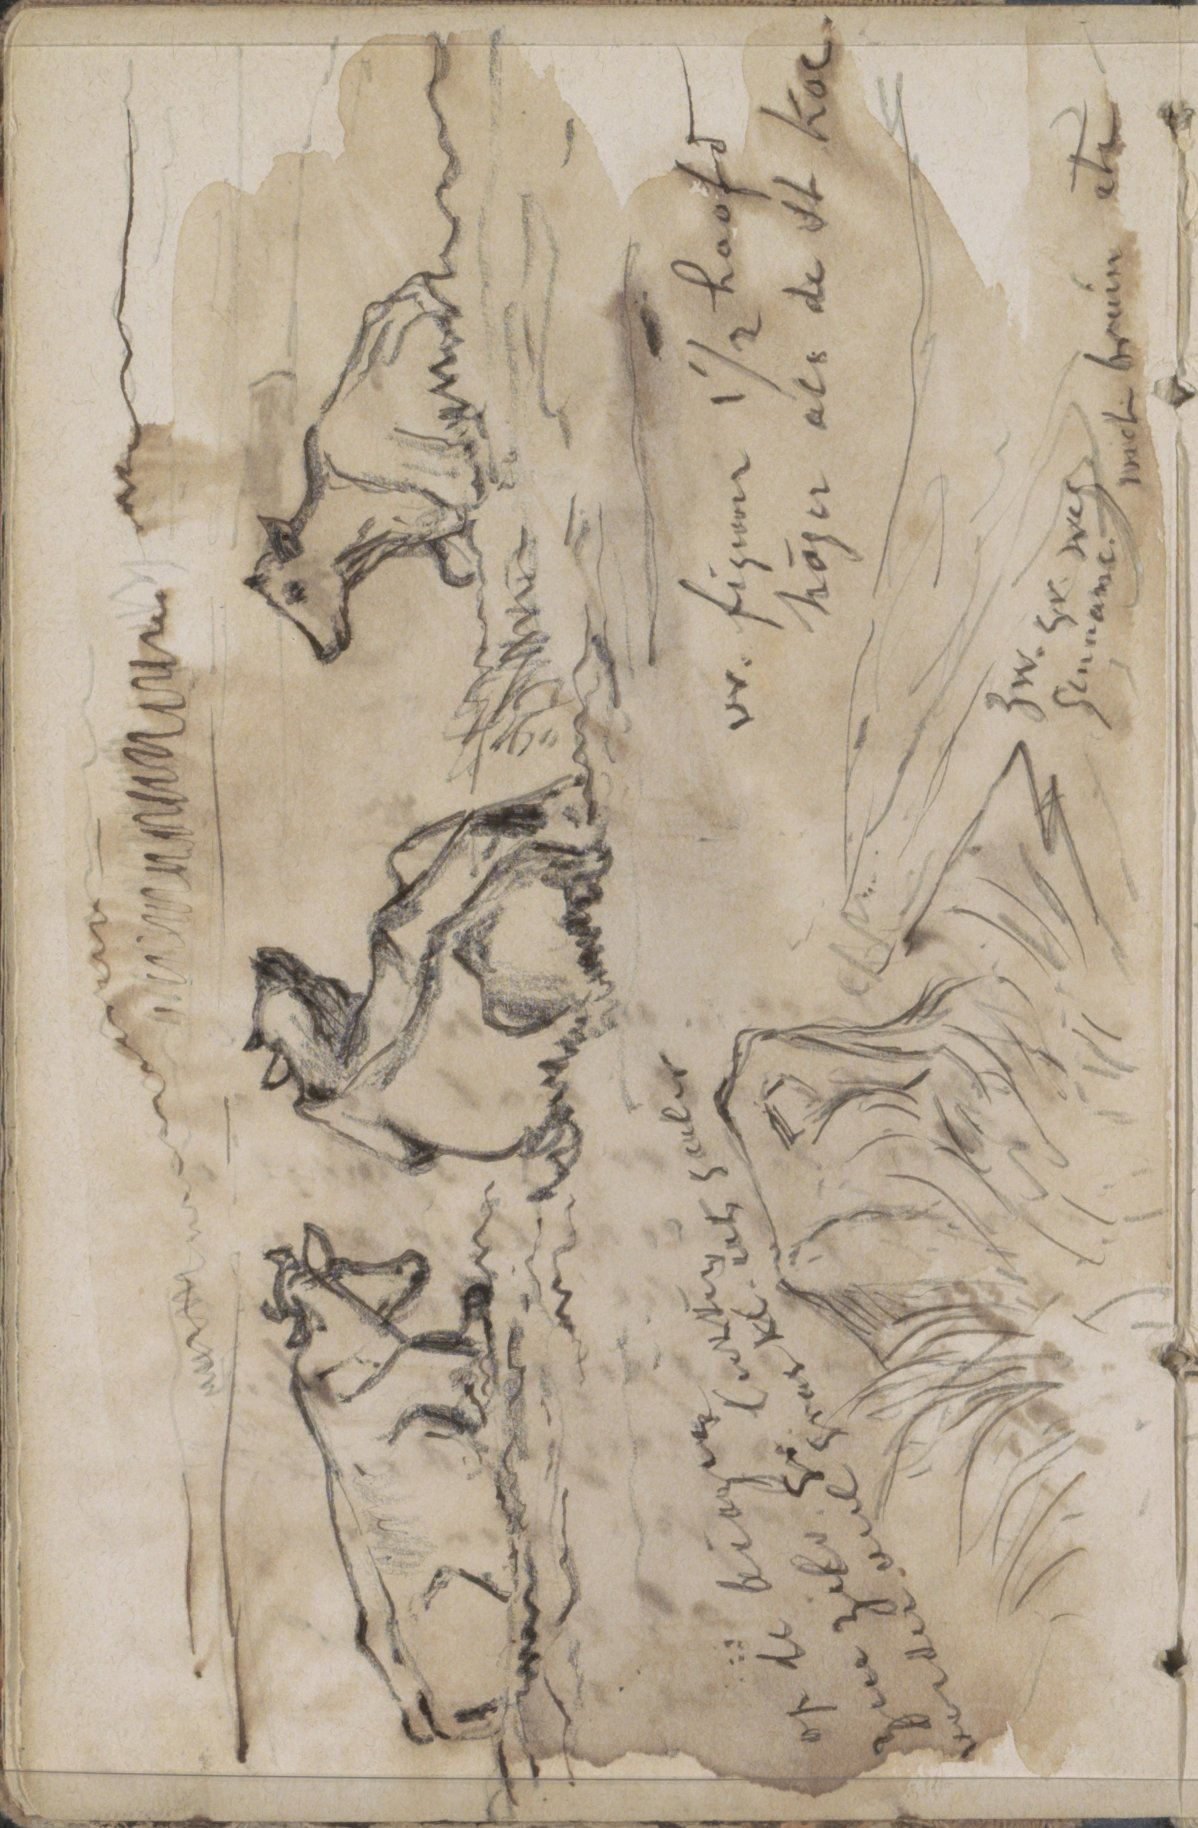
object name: sketchbook leaf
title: Liggende koeien in een weiland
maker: johannes tavenraat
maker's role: draughtsman, painter, print maker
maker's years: 1809-1881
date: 1862-1864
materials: ink, paper, pencil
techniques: brush, pen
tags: cow, meadow, pasture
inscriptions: kleurnotitie, handgeschreven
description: Blad 2 verso uit een schetsboek met 65 bladen.